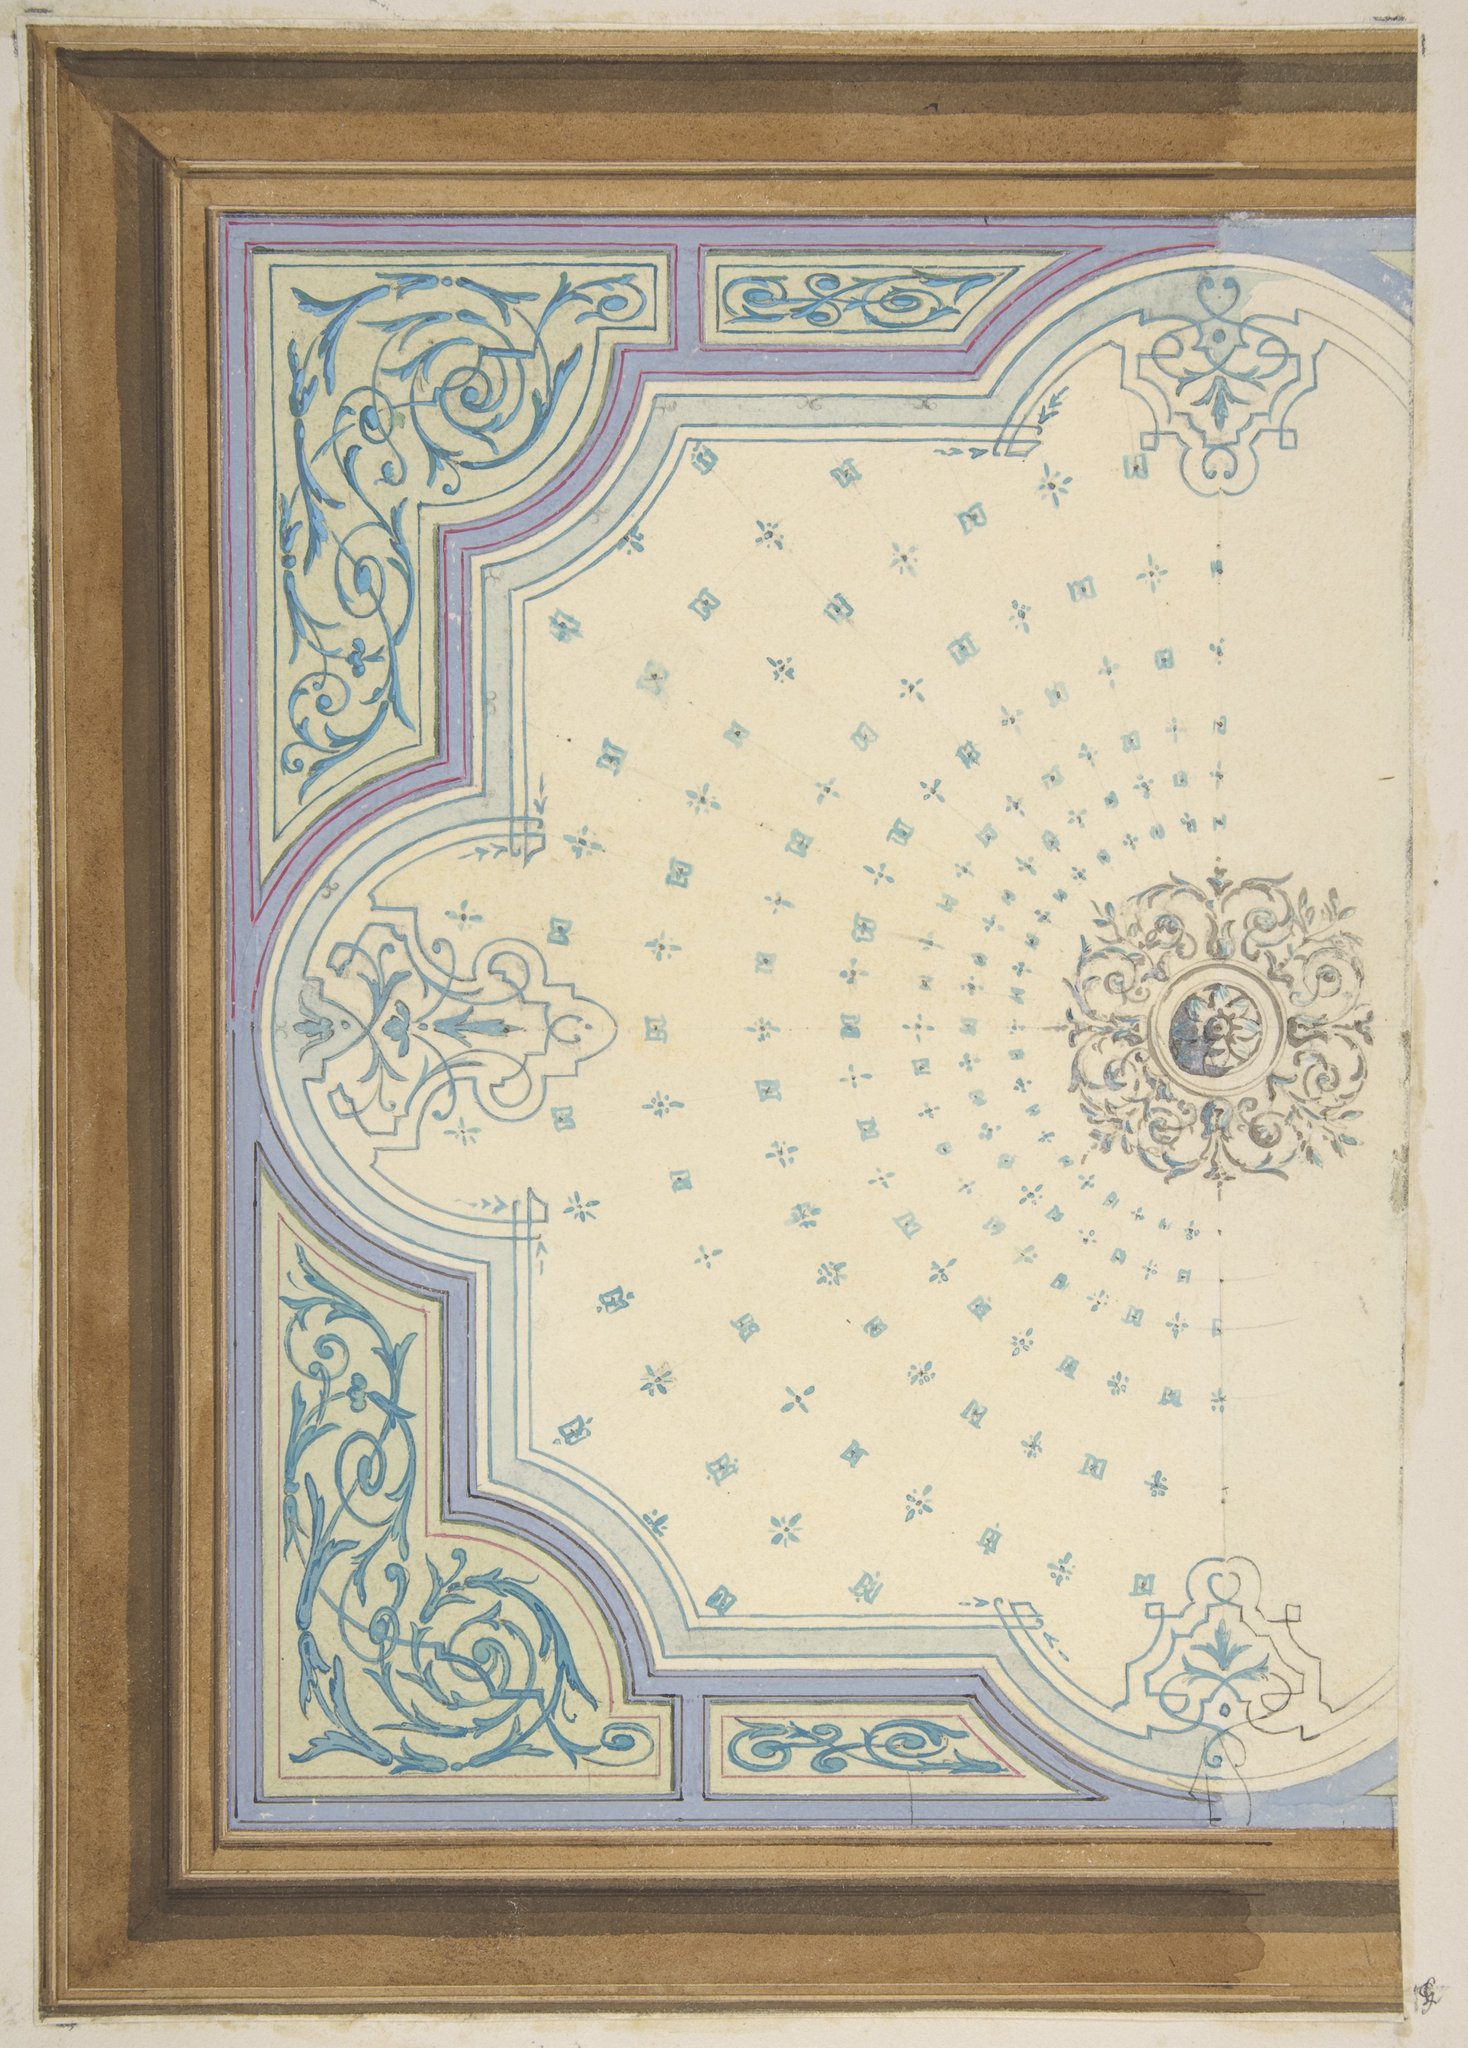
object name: drawing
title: Design for the decoration of a ceiling with strapwork and rinceaux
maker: jules-edmond-charles lachaise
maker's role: artist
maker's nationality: french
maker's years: 1897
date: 1830-1897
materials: ink, watercolor, paper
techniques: pen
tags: ceilings